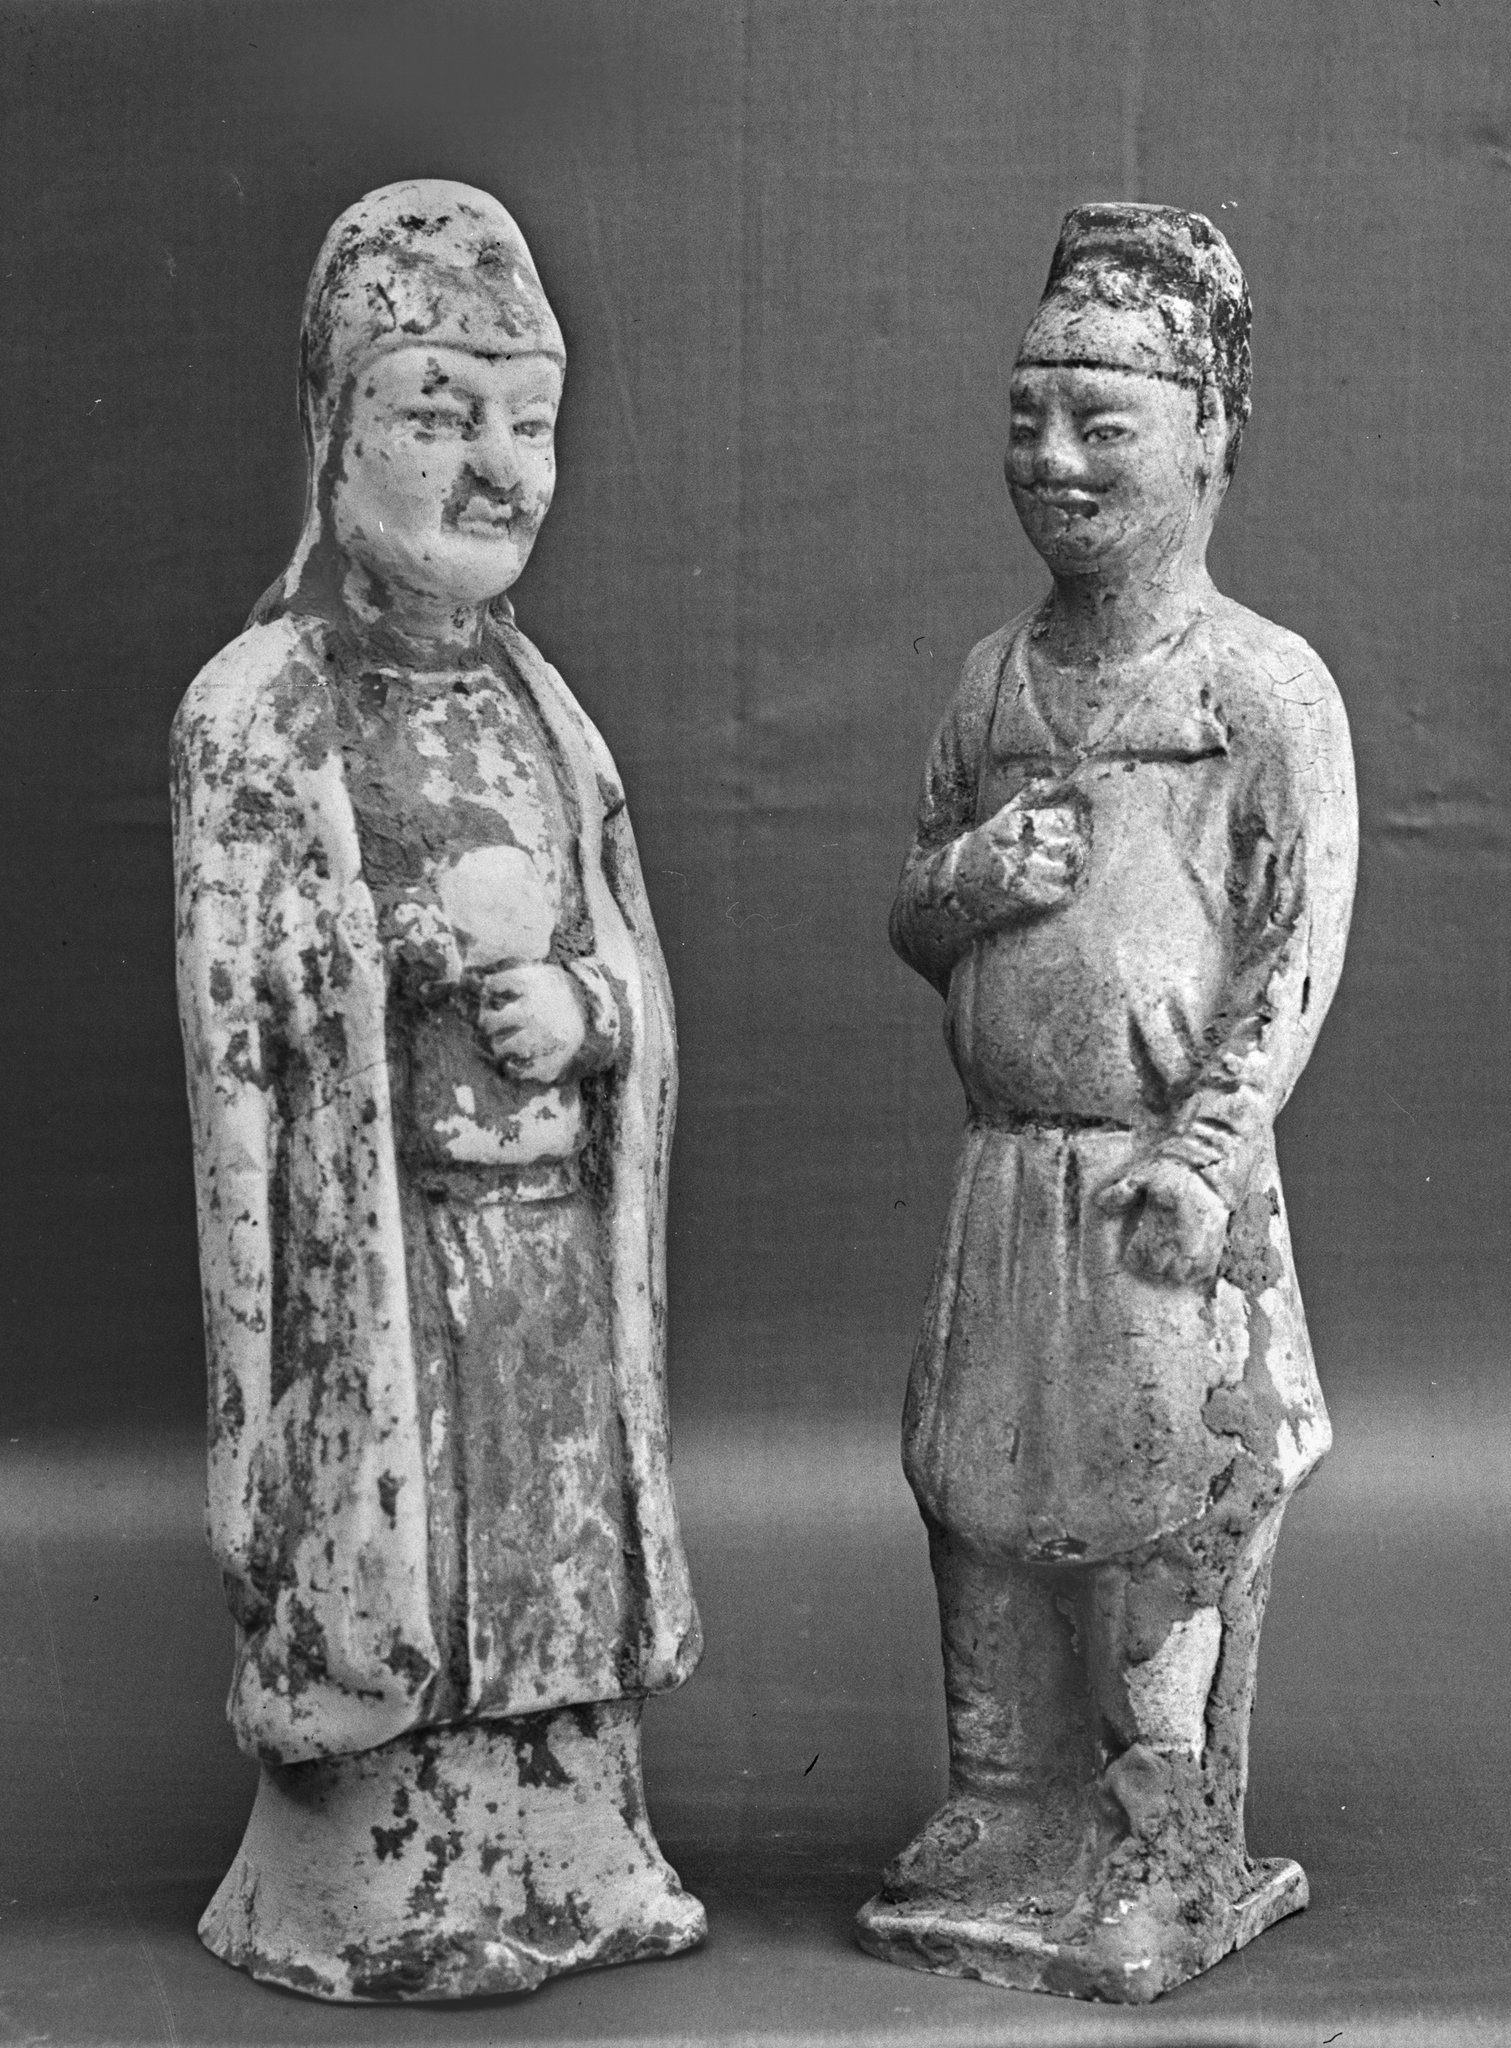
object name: figure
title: Figure of a standing man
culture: chinese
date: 601-800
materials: earthenware, glaze, pigment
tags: men